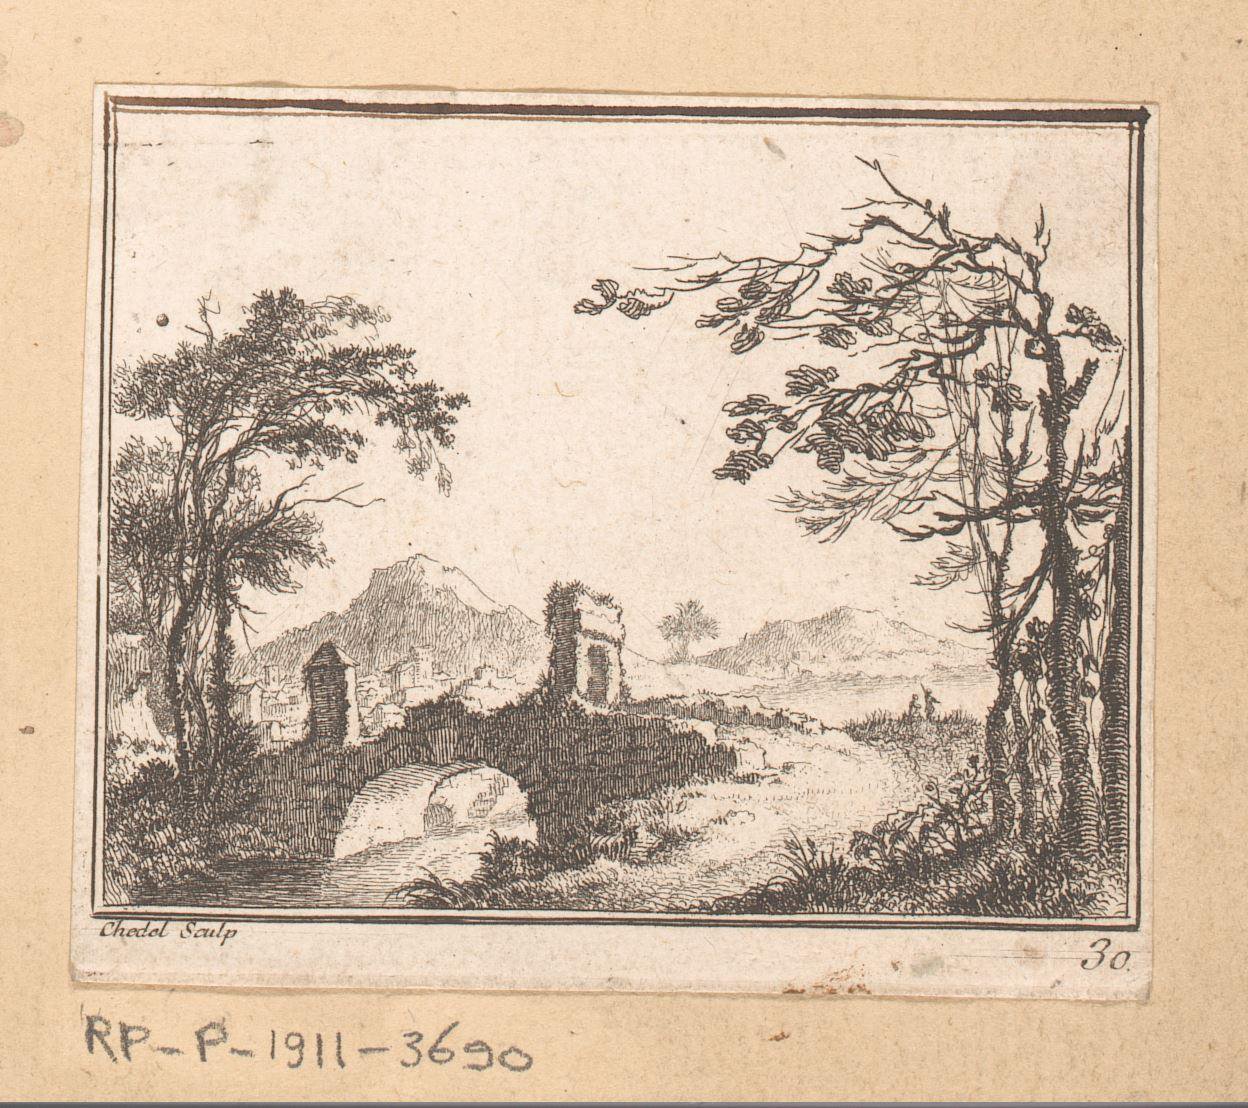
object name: print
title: Landschap met een brug waarop een poort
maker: pierre quentin chedel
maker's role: draughtsman, print maker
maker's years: 1705-1763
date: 1725-1763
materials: ink, paper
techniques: etching, pen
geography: france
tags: landscape with bridge, viaduct or aqueduct, gate, entrance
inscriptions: collector's mark: Lugt 2228